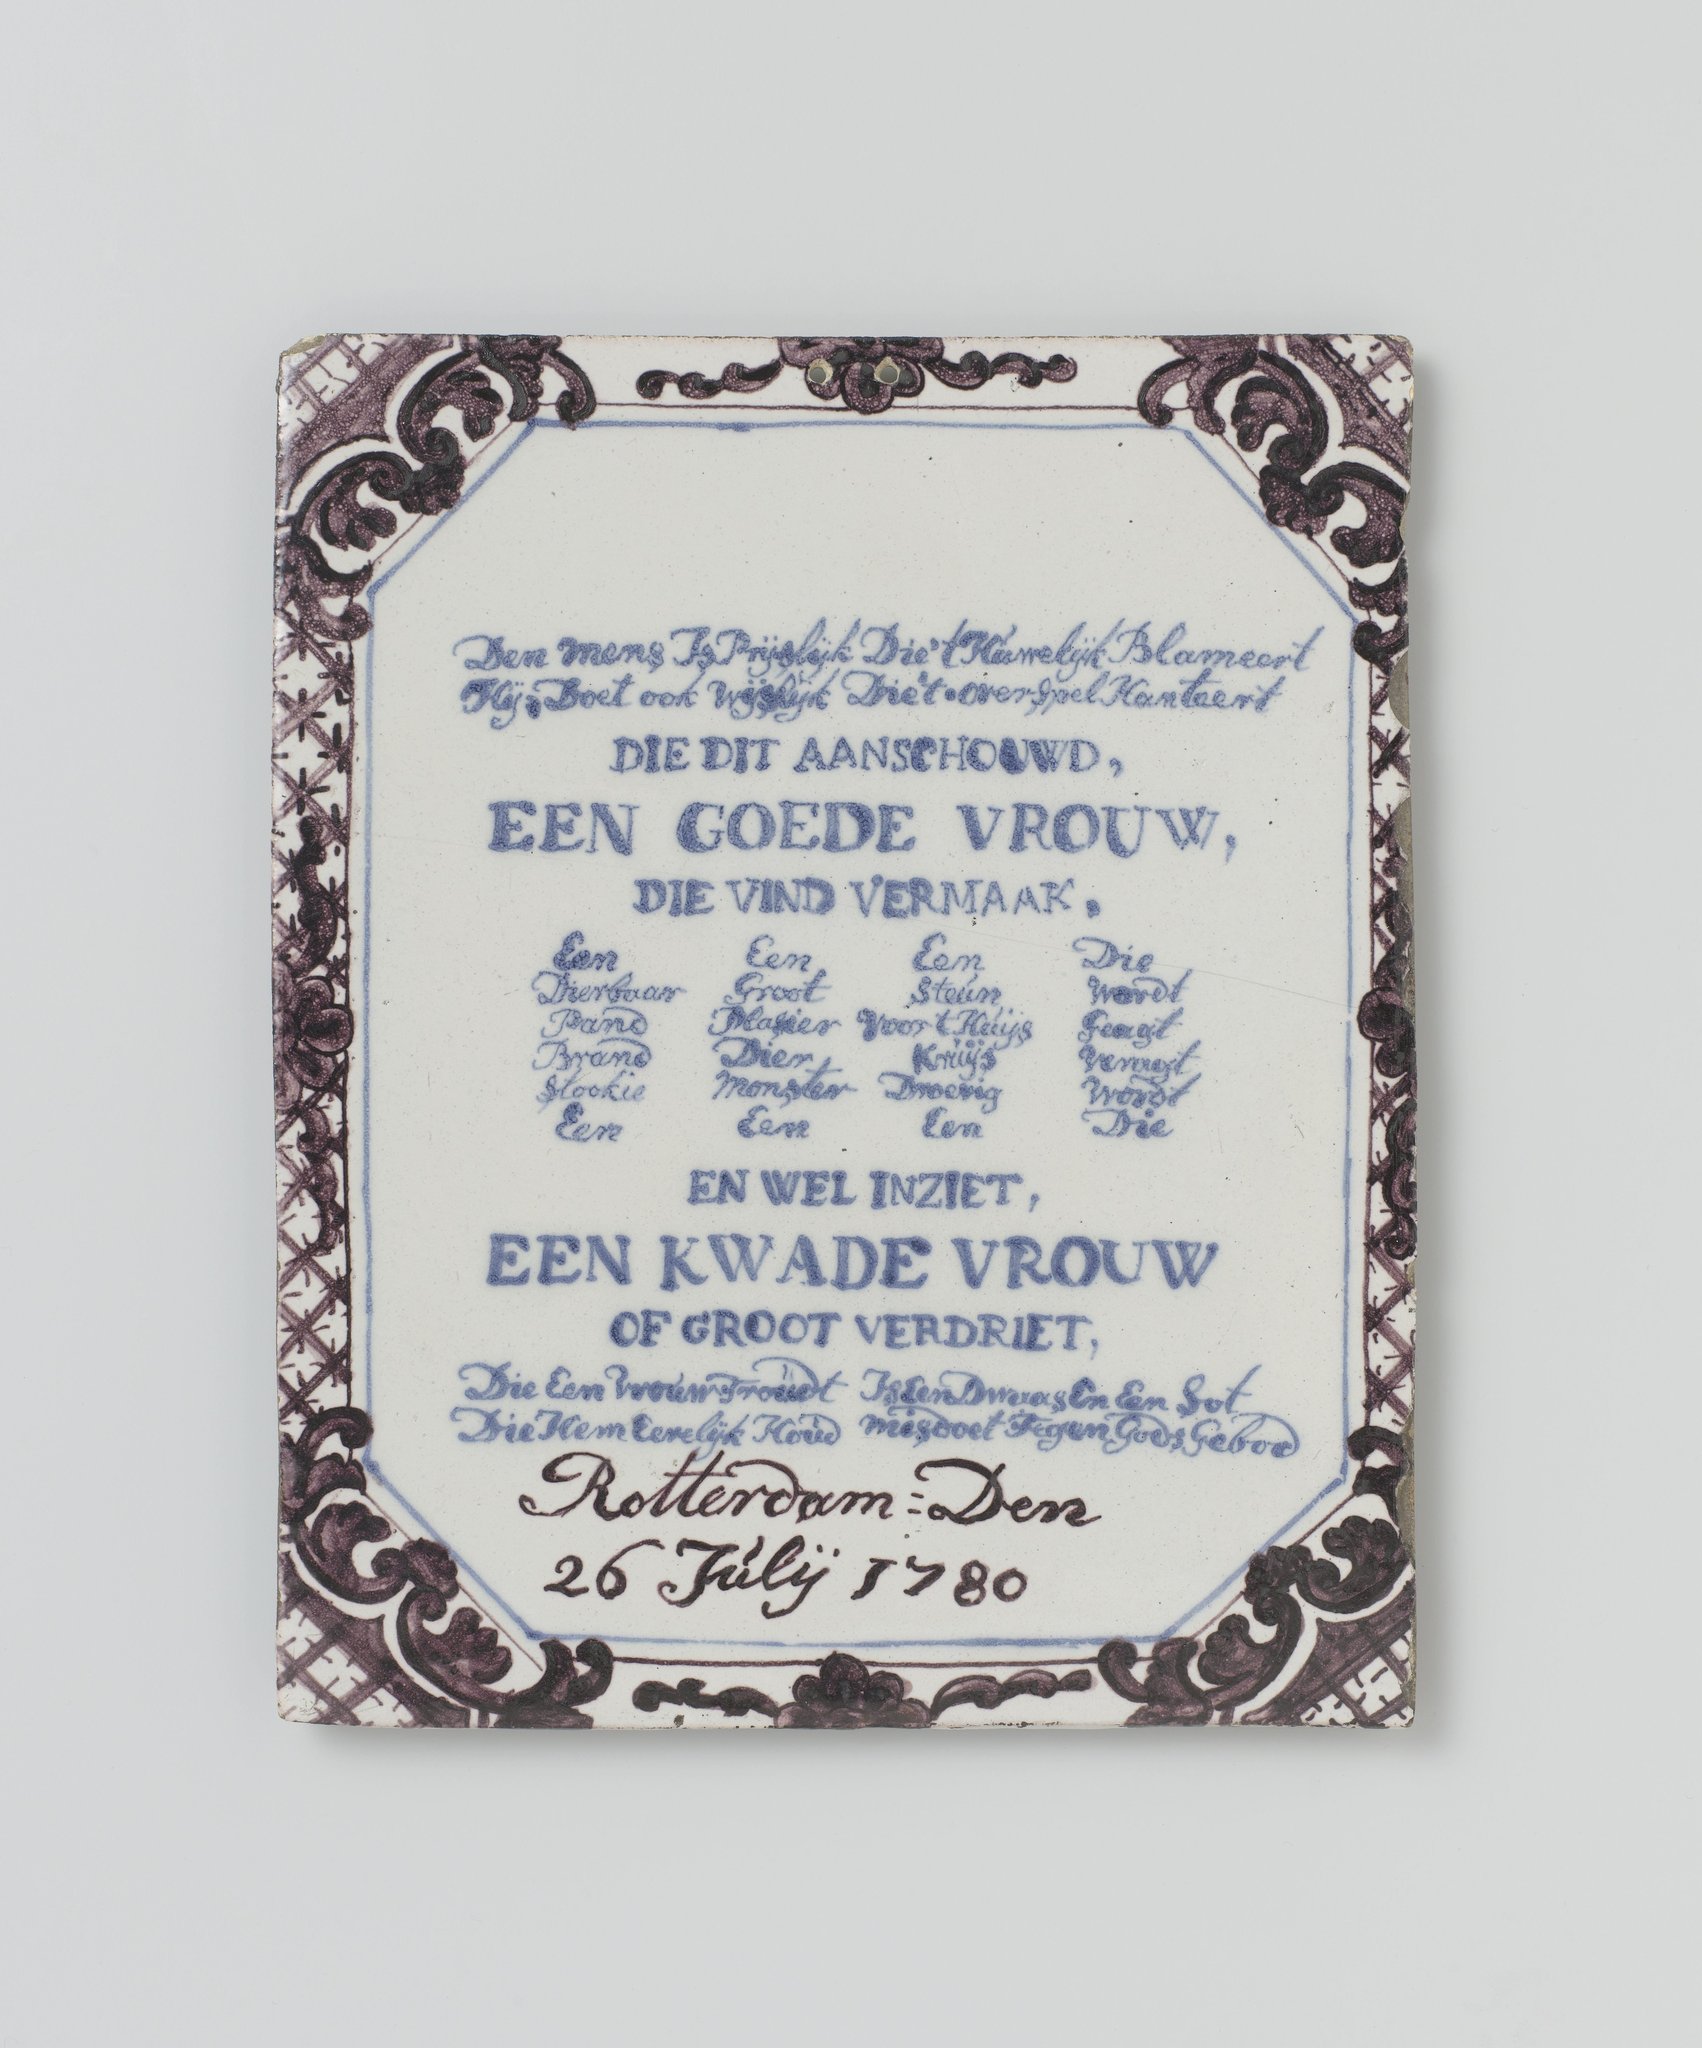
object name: tile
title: Tegel met spreuk die betrekking heeft op het huwelijk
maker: Anonymous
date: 1780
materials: earthenware, glaze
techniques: painted, polychromy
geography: rotterdam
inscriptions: inscription: ‘Rotterdam = Den/ 26 Julij 1780’, inscription: ‘Is Een Dwaas En Een Sot/ misdoet Tegen Gods Gebod/’, inscription: ‘Den mens Is Prijslijk Die 't Huwelijk Blameert/ Hij Boet ook wijslijk Die 't overspel Hanteert’, inscription: ‘Die/ wordt/ Geagt/ Verwagt/ Wordt/ Die’, inscription: ‘Een/ Dierbaar/ Pand/ Brand/ Stookie/ Een’, inscription: ‘Die Een Vrouw Troudt/ Die Hem Eerlijk Houd/’, inscription: ‘DIE DIT AANSCHOUWD,/ EEN GOEDE VROUW,/ DIE VIND VERMAAK,’, inscription: ‘EN WEL INZIET,/ EEN KWADE VROUW/ OF GROOT VERDRIET,/’, inscription: ‘Een/ Groot/ Plasier/ Dier/ Monster/ Een’, inscription: ‘Een/ Steun/ Voor t Huijs/ Kruijs/ Droevig/ Een’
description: Rechthoekige tegel van veelkleurig beschilderde faïence. Op de tegel staat binnen een mangaankleurige omlijsting een spreuk die betrekking heeft op het huwelijk. De tegel is gedateerd: 26 juli 1780.